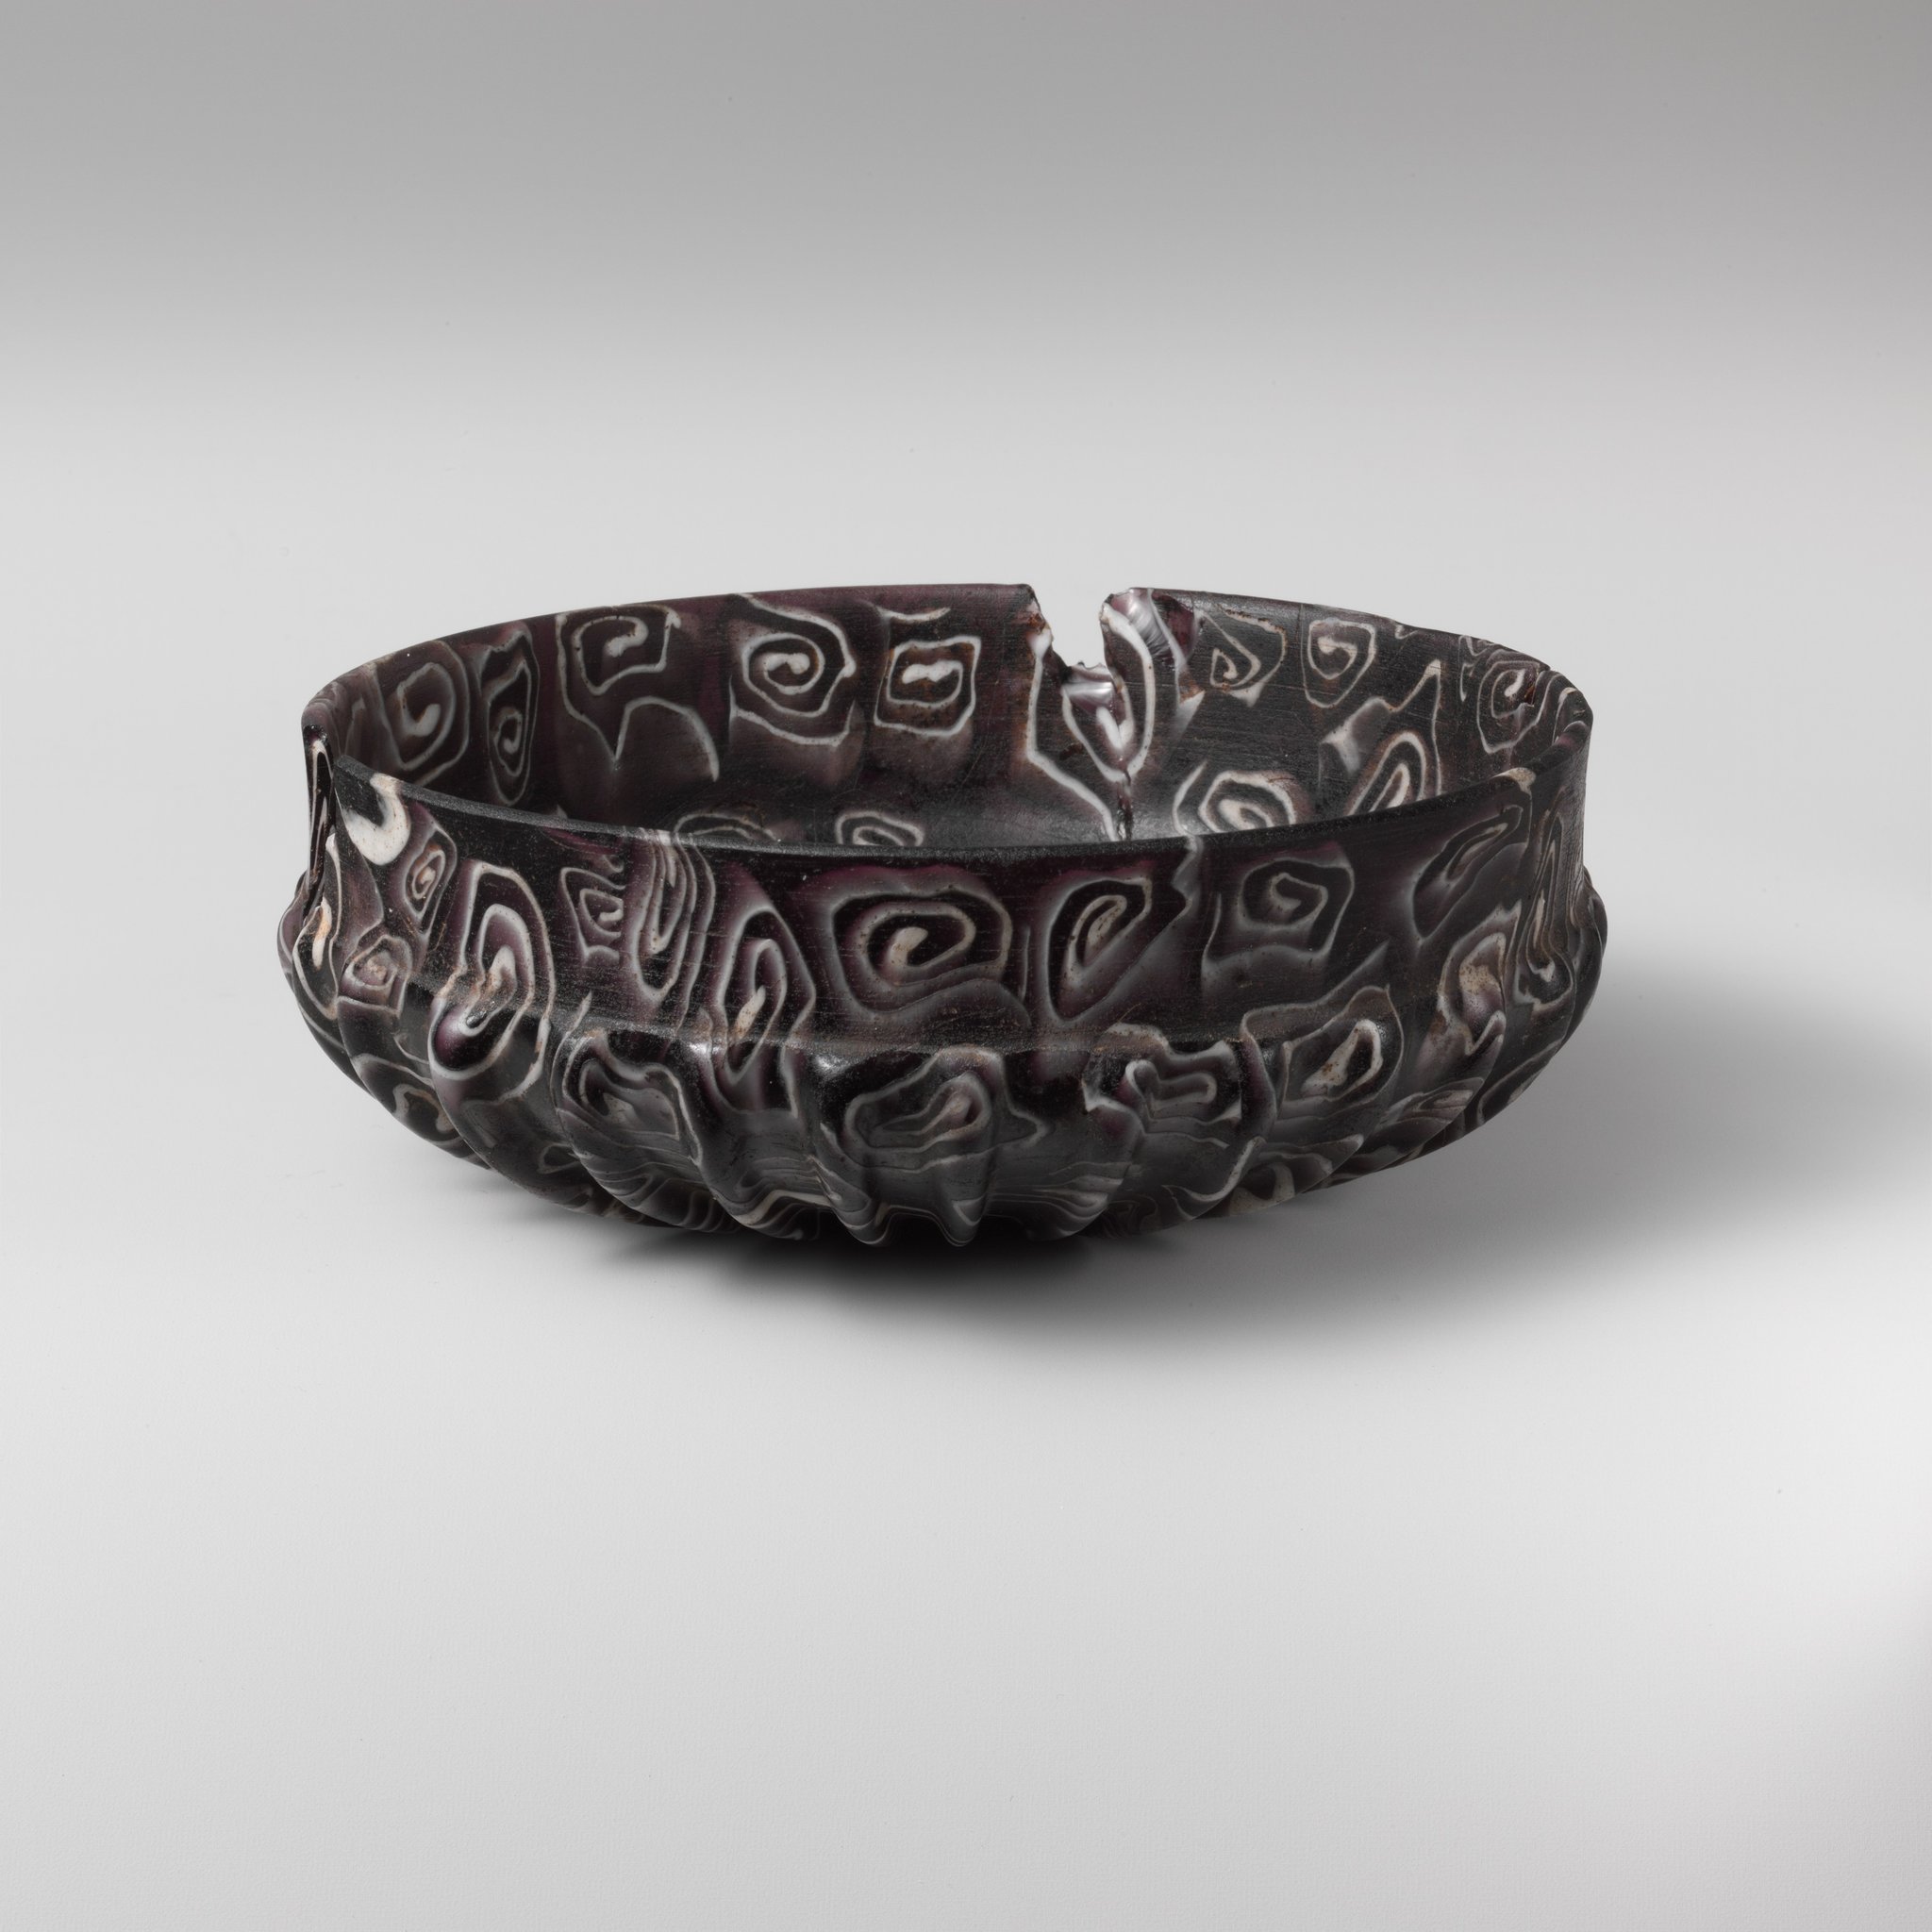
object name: bowl, mosaic, ribbed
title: Glass mosaic ribbed bowl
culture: roman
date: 34 BCE-33 CE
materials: glass